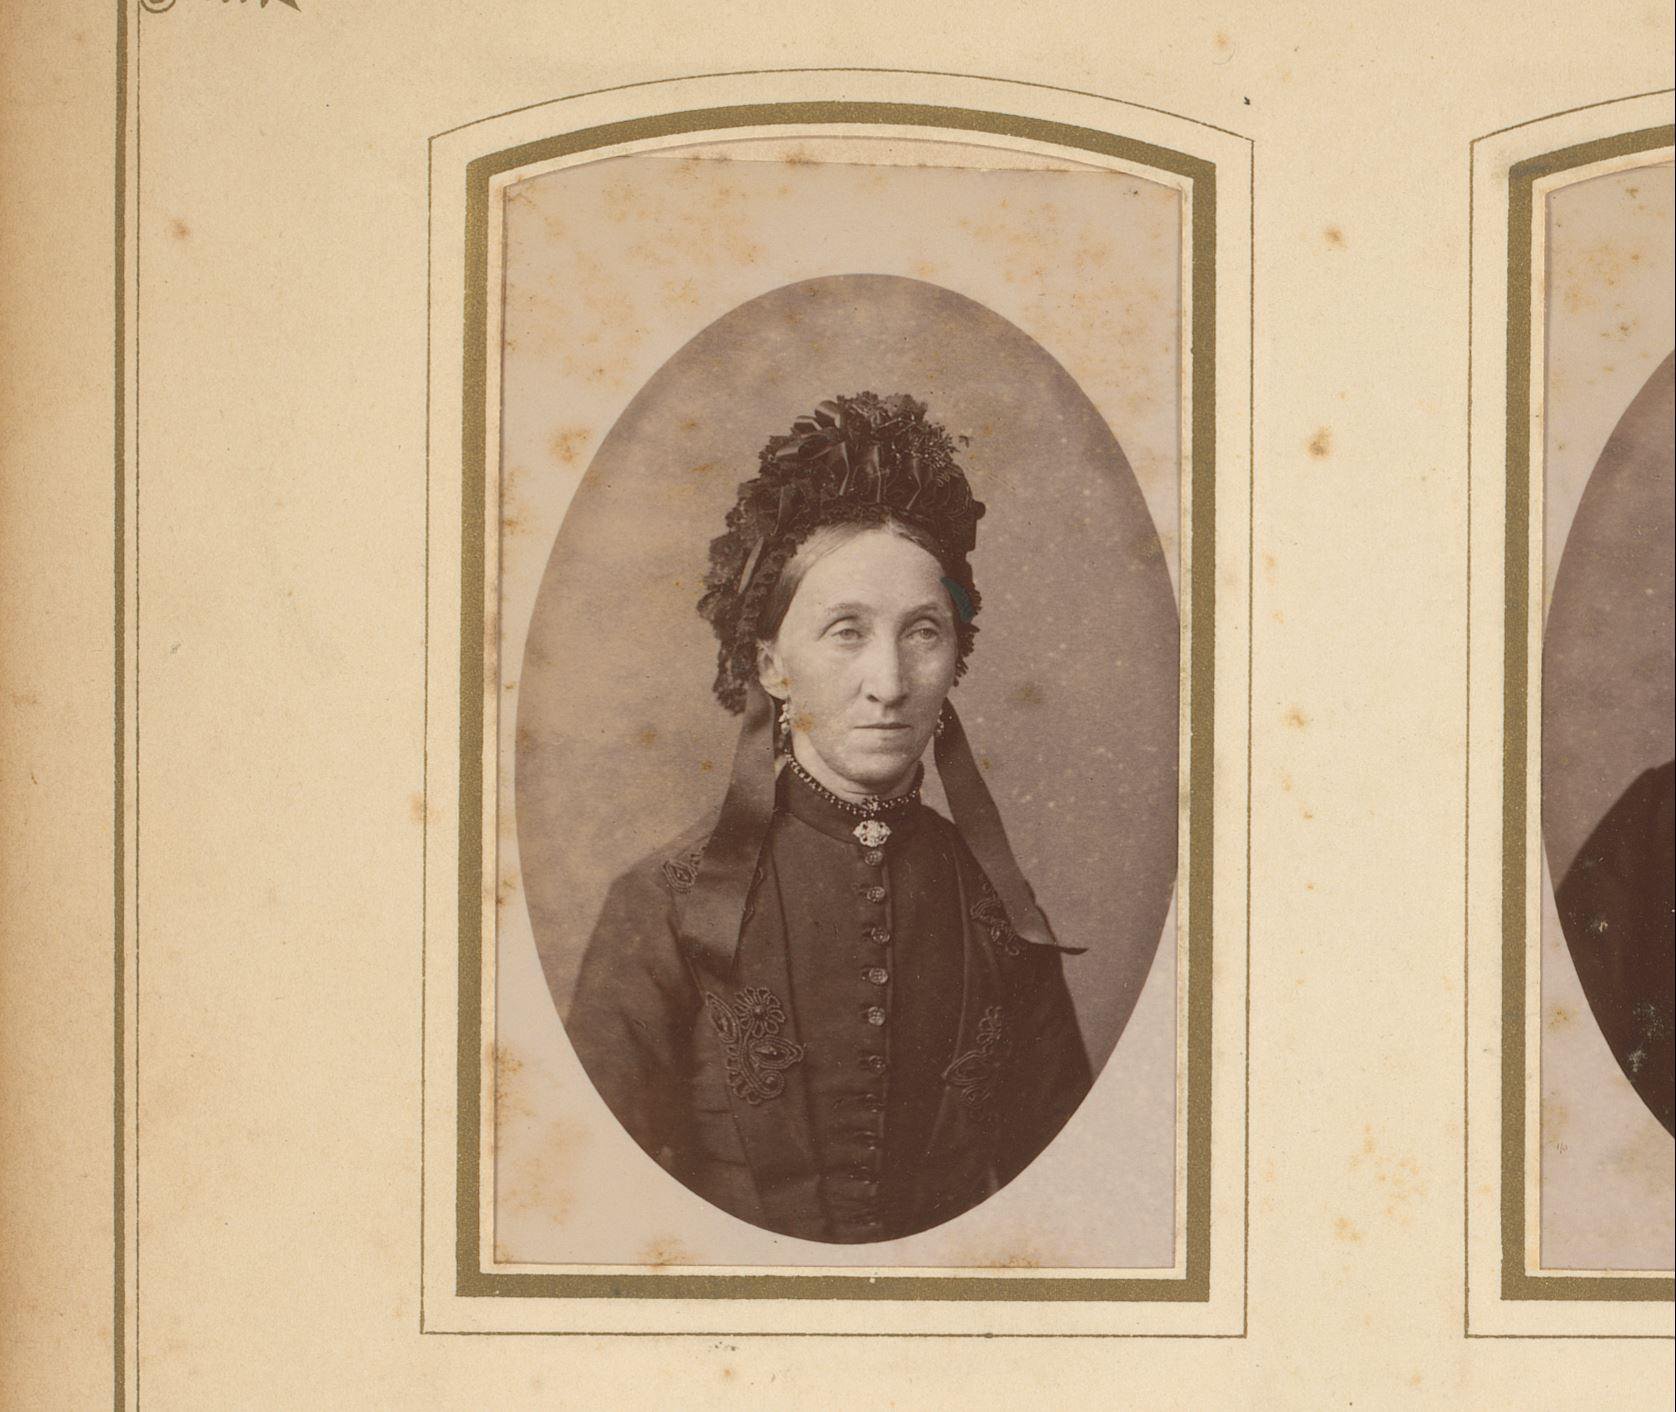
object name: album leaf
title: Portret van een vrouw met muts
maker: roelof hinderikus christiaan karsses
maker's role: fotograaf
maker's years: 1845-1941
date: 1860-1900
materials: cardboard, photographic support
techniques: albumen print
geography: groningen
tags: historical persons - bb - woman, head-gear: cap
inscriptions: inscription: ‘Photographie/ R. H. C. Karsses/ No Y 1114/ Heereweg/ tegenover de Rabenhauptstraat/ Groningen’